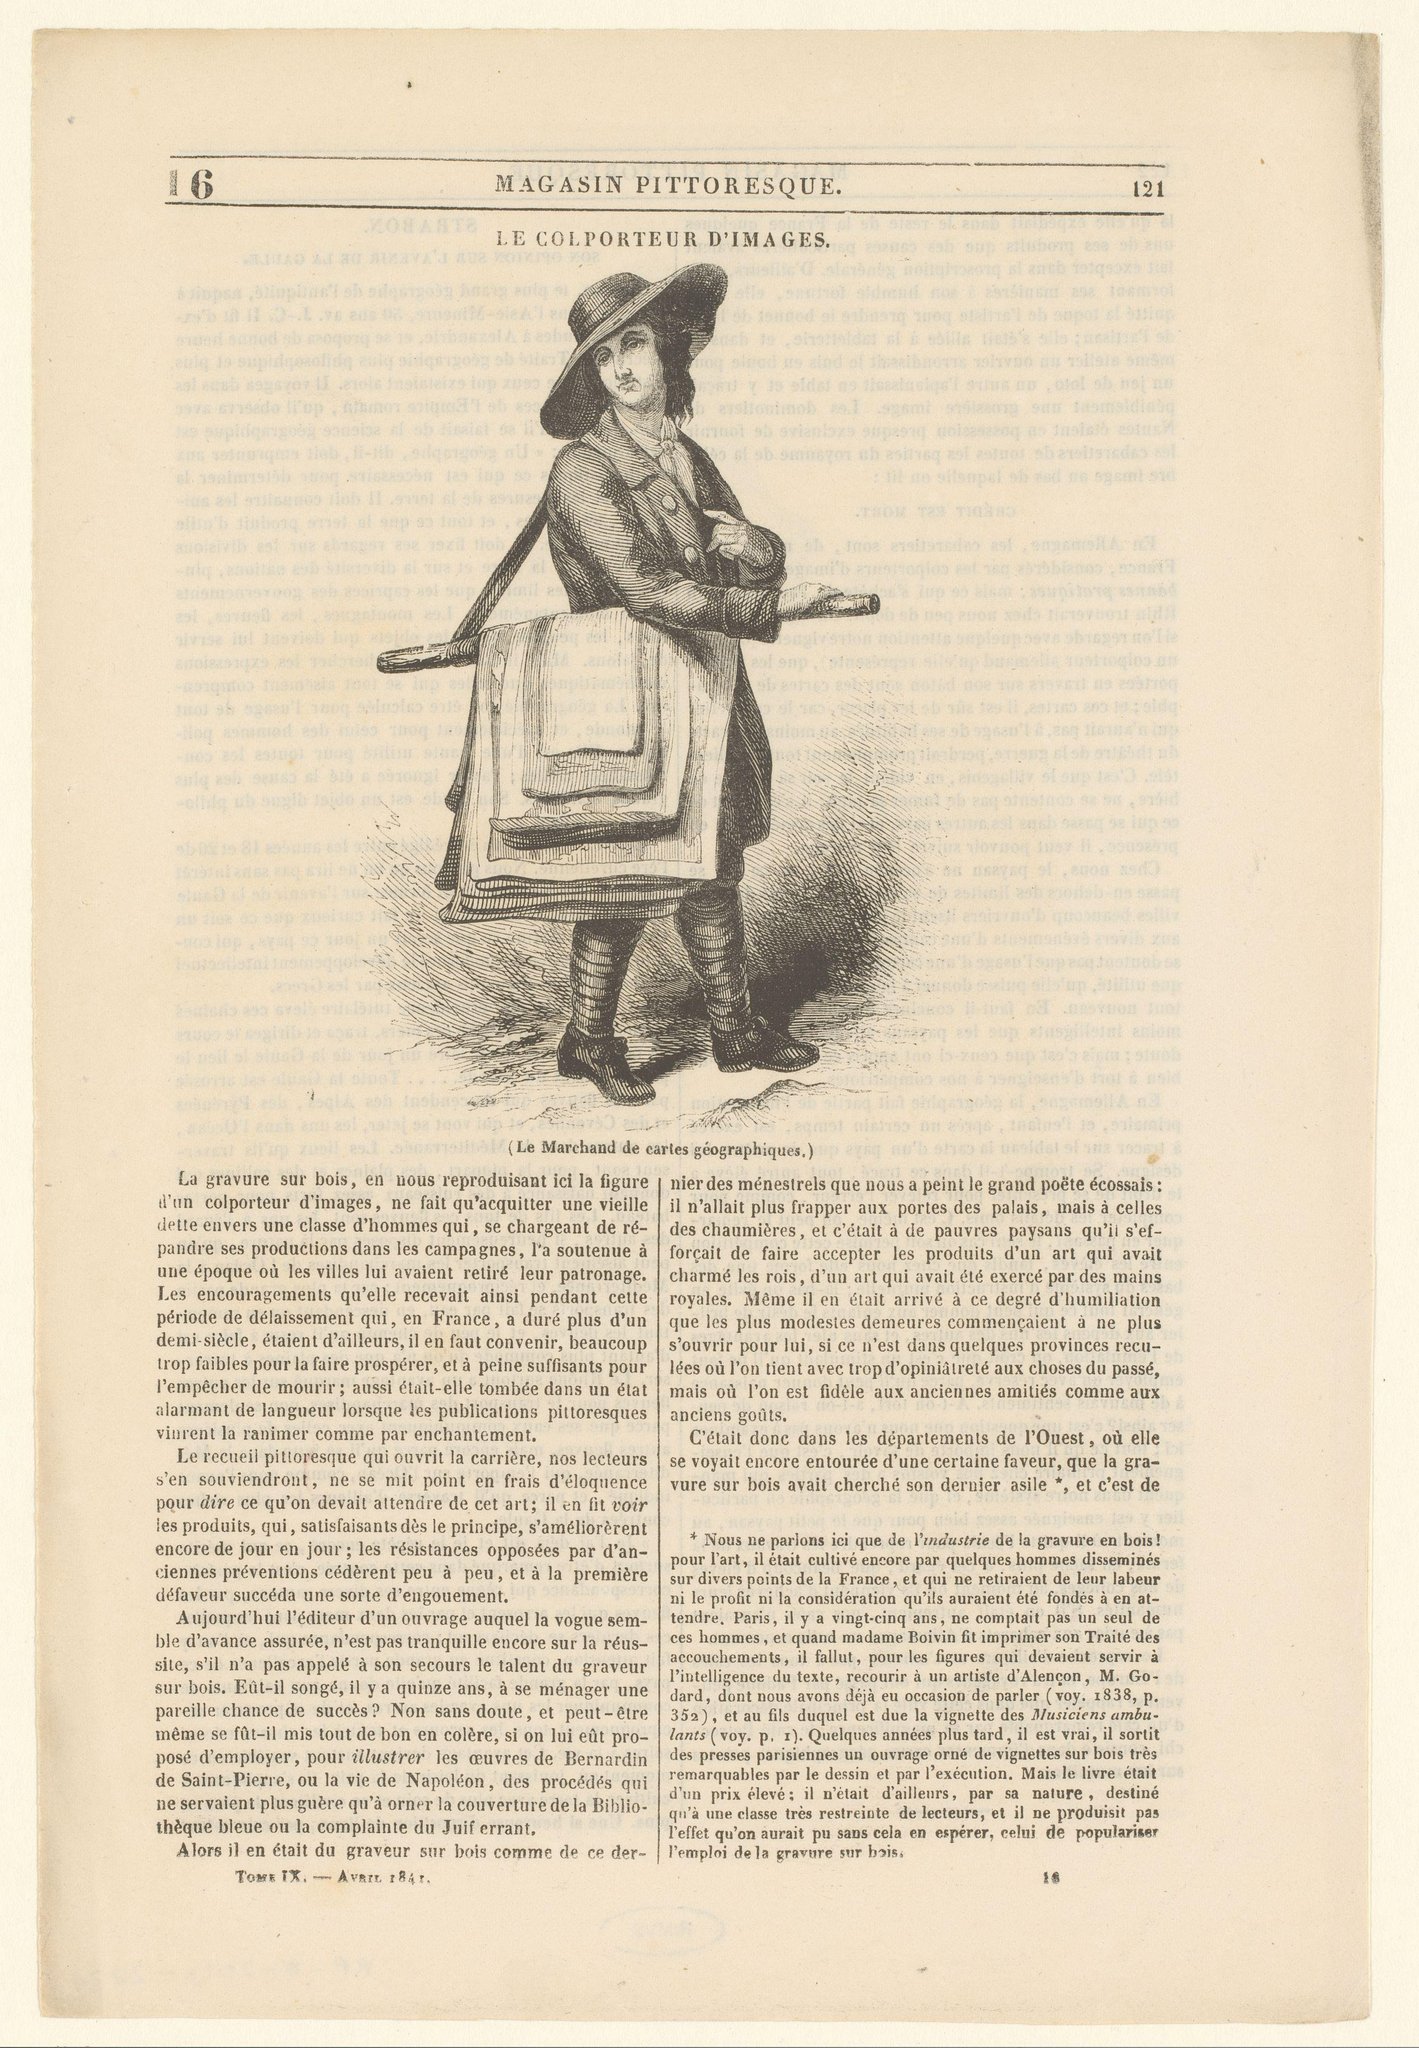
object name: magazine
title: Prentverkoper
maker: Anonymous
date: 1841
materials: paper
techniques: letterpress printing, lithograph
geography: france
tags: print, e.g.: engraving, etching, lithograph, street-trader, merchant, salesman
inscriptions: collector's mark: Lugt 2228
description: Gepubliceerd in 'Le Magasin Pittoresque', 1841, dl. 16, p. 121.